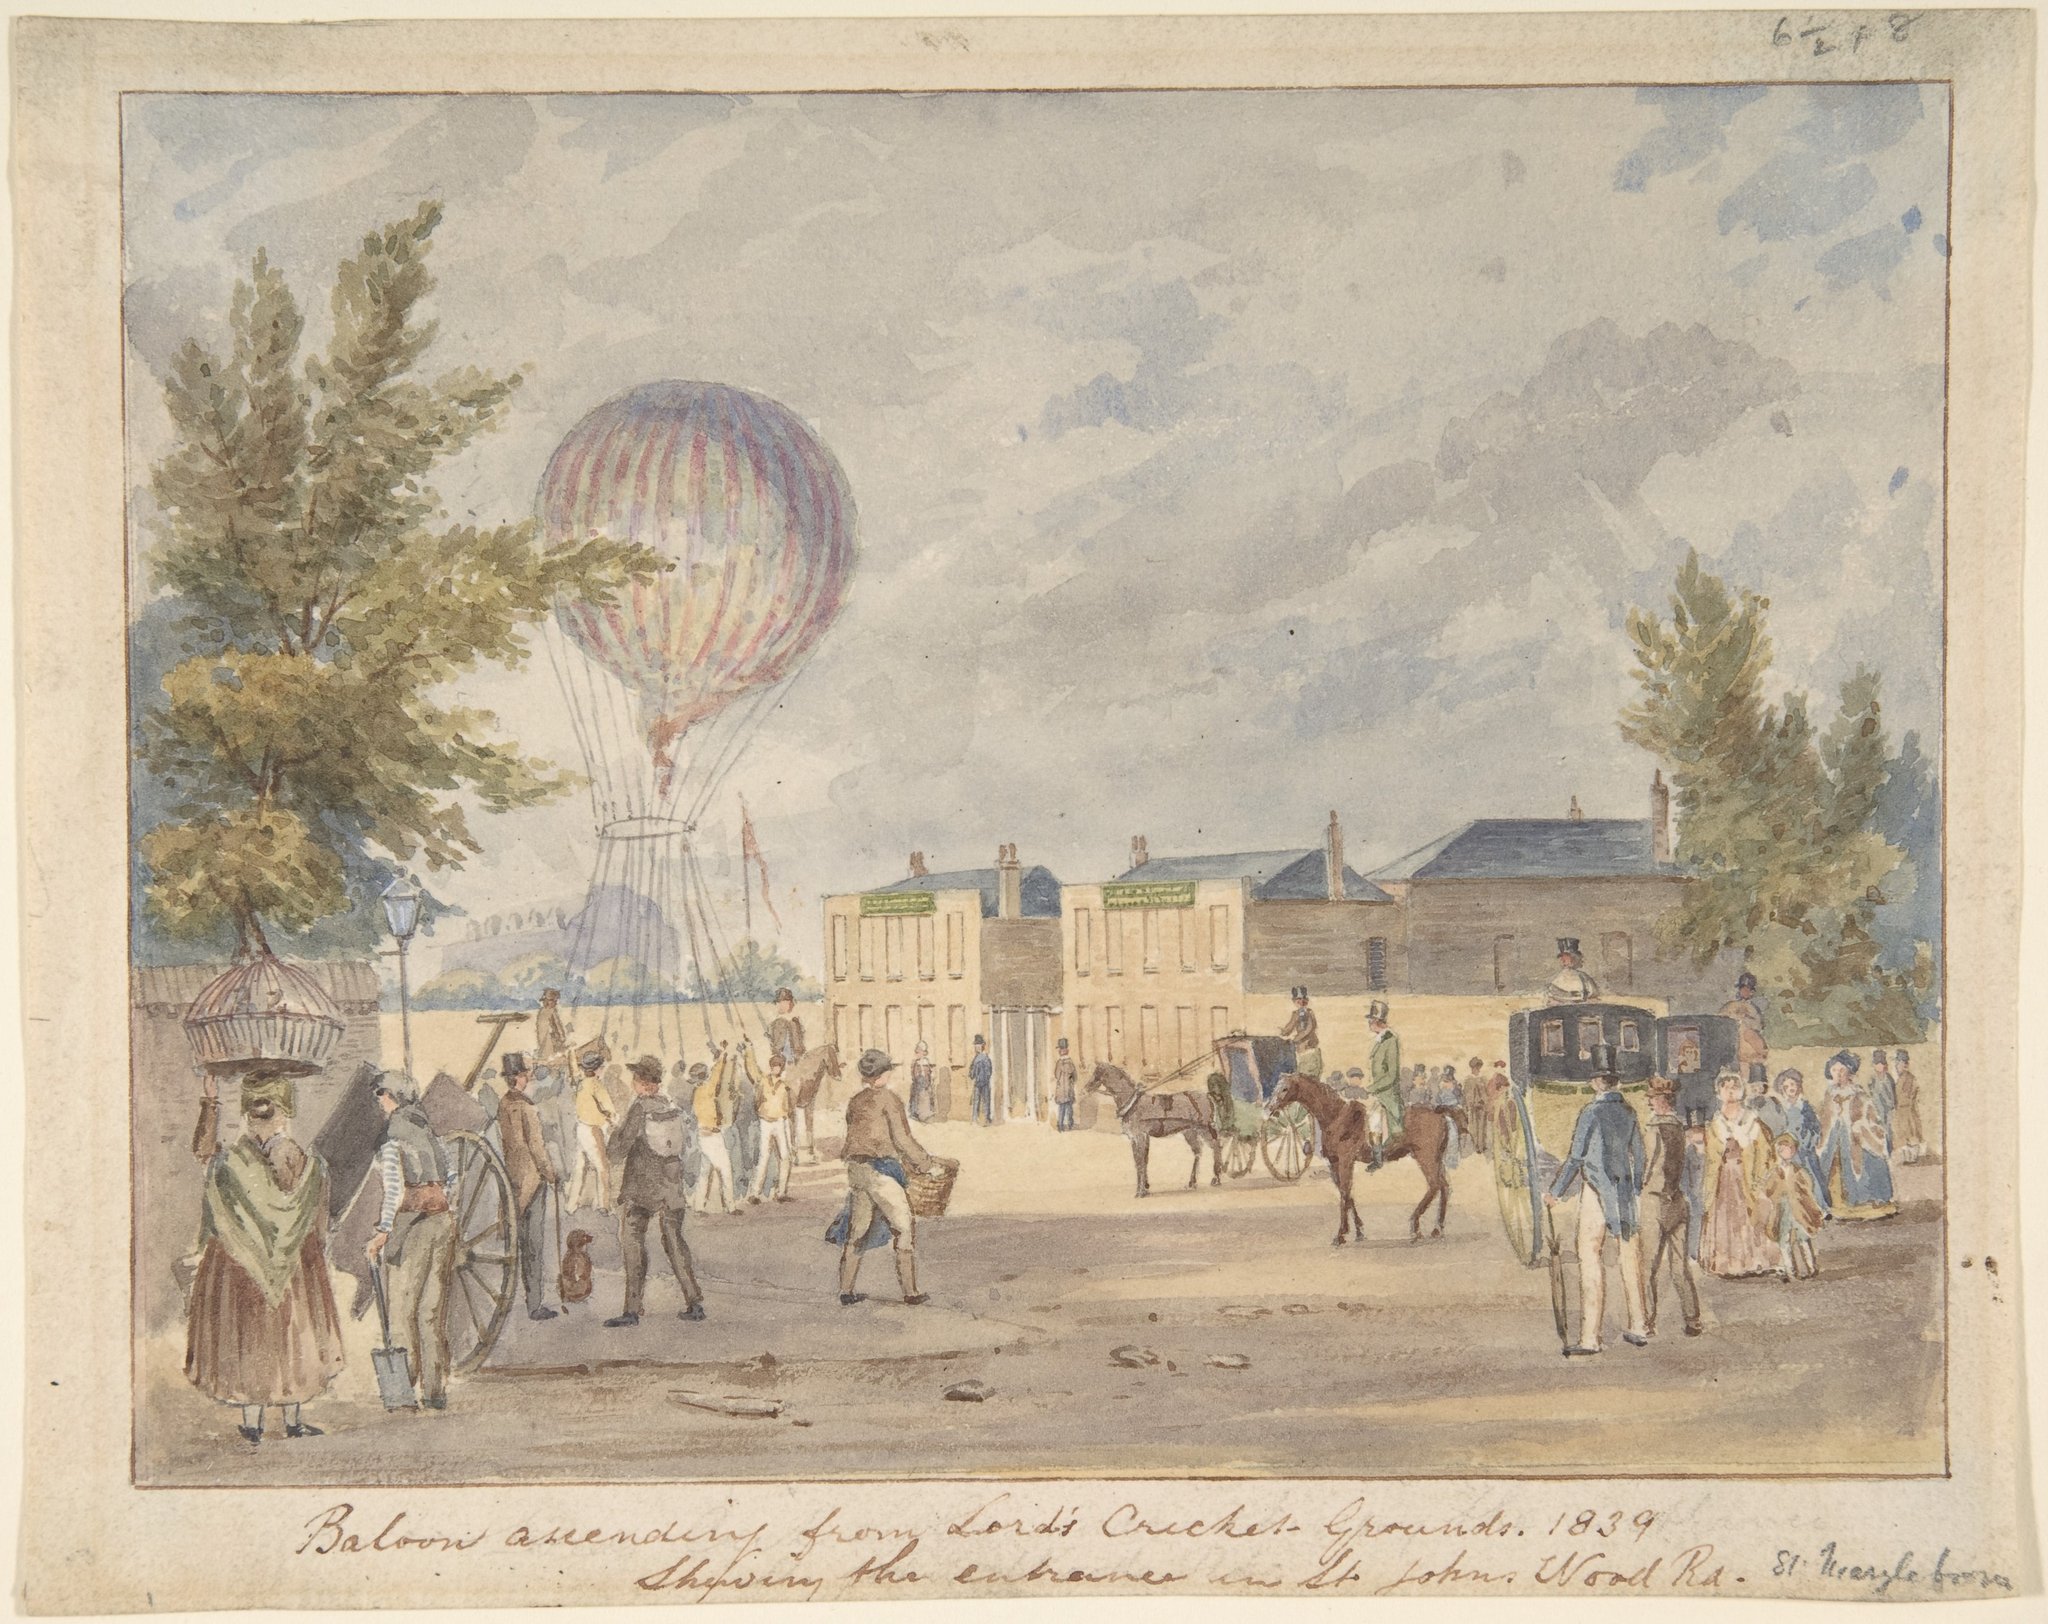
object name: drawing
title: Balloon Ascending Near the Entrance to Lord's Cricket Ground, 1839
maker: robert bremmel schnebbelie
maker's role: artist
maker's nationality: british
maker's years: 1803-1849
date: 1839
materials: watercolor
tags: men,women,carriages,hot air balloons,london